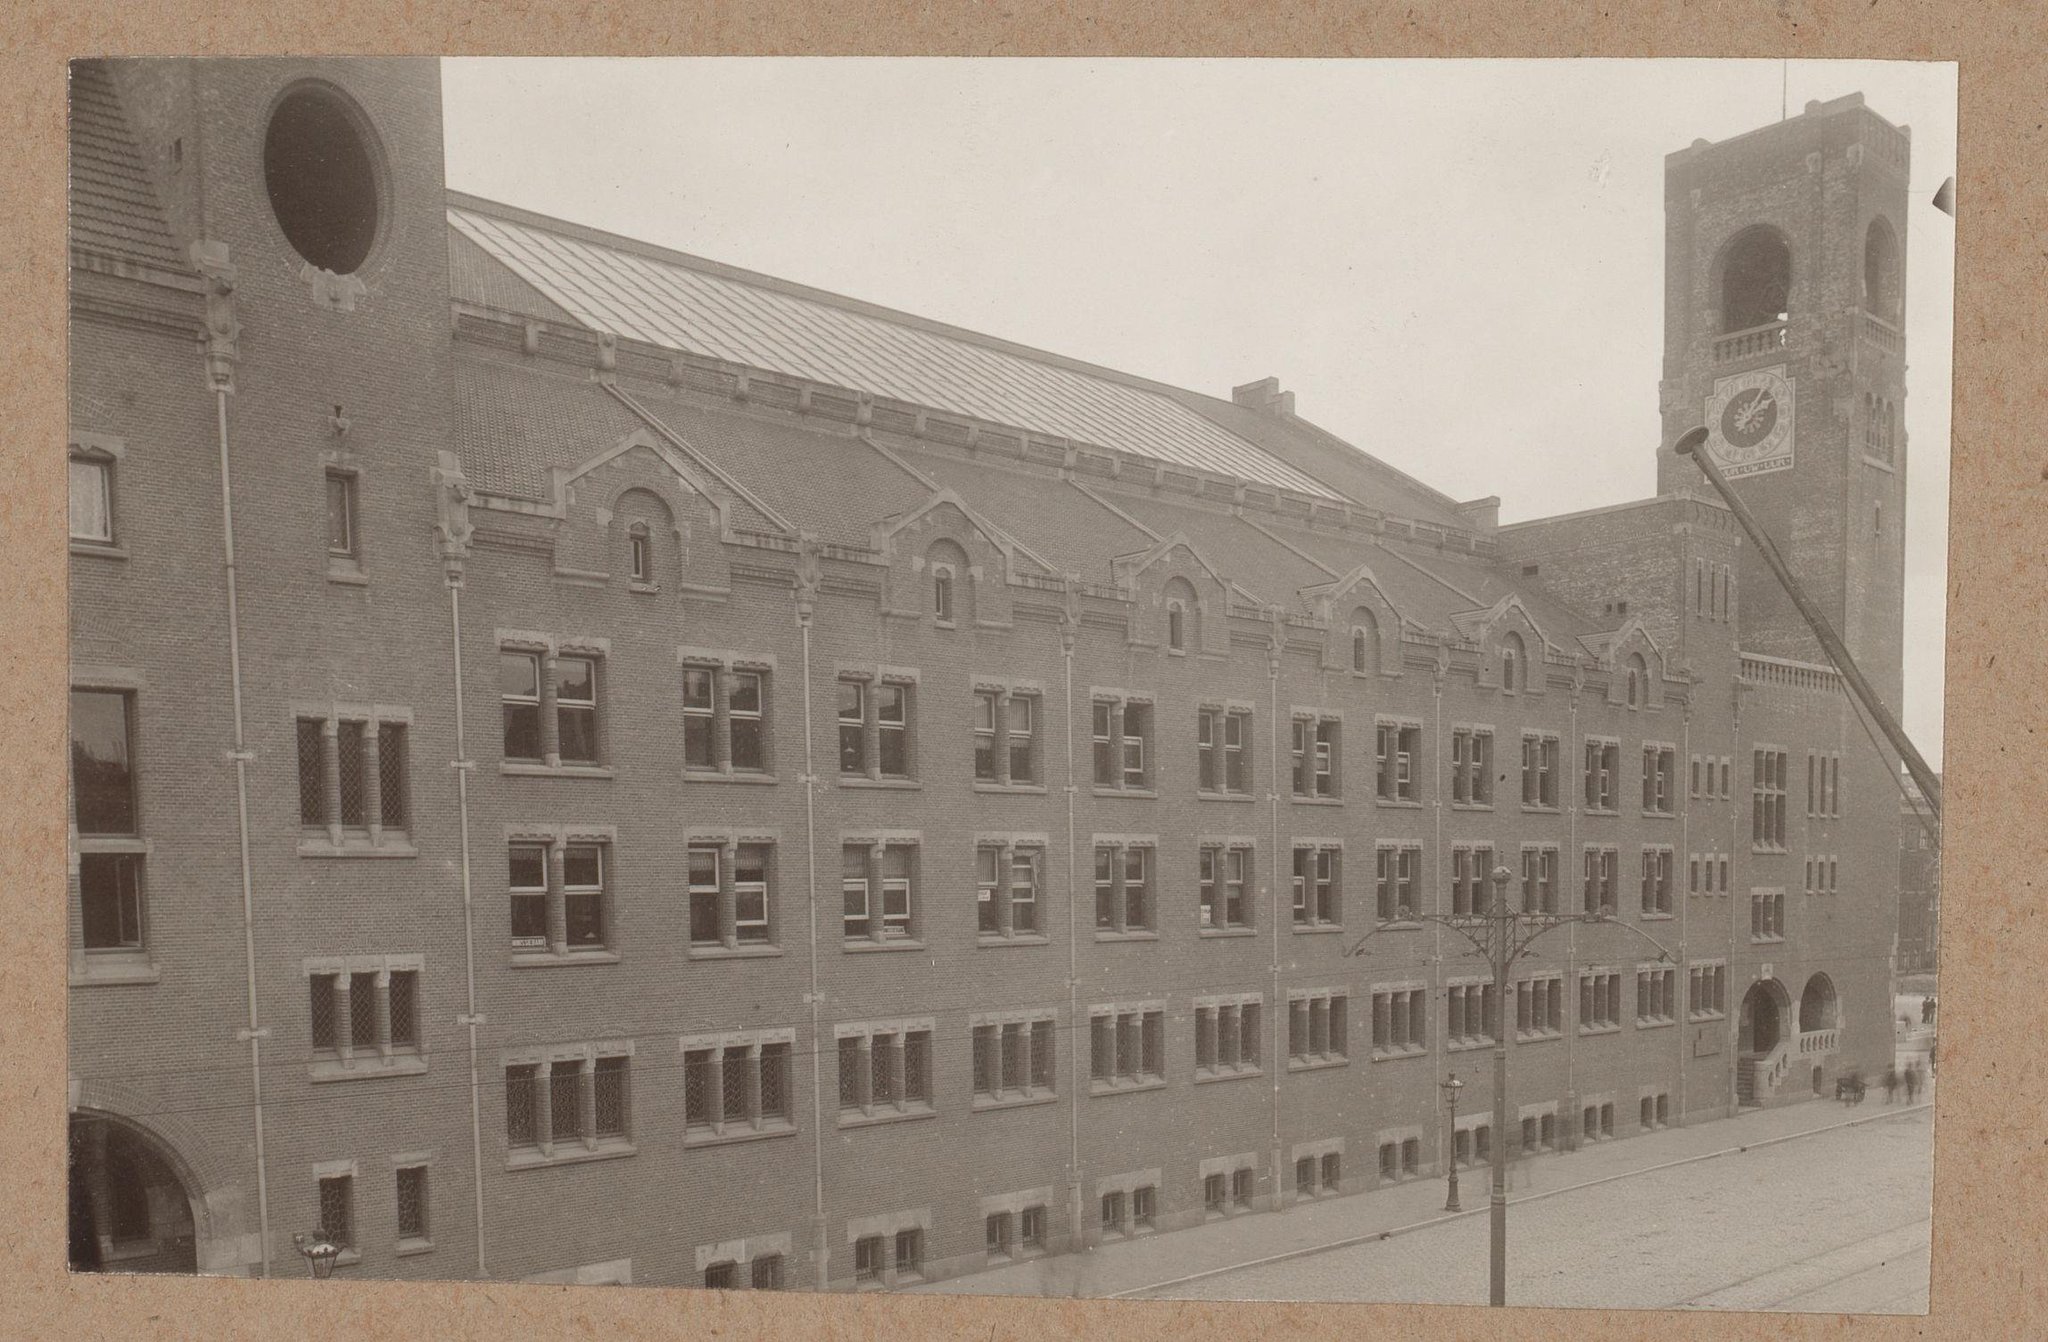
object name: photograph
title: Gevel aan het Damrak van de Beurs van Berlage te Amsterdam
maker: Anonymous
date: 1903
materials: paper, cardboard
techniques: gelatin silver print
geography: amsterdam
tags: stock exchange, stock-market, front façade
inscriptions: stamp: ‘Rijksmuseum/ Amsterdam’